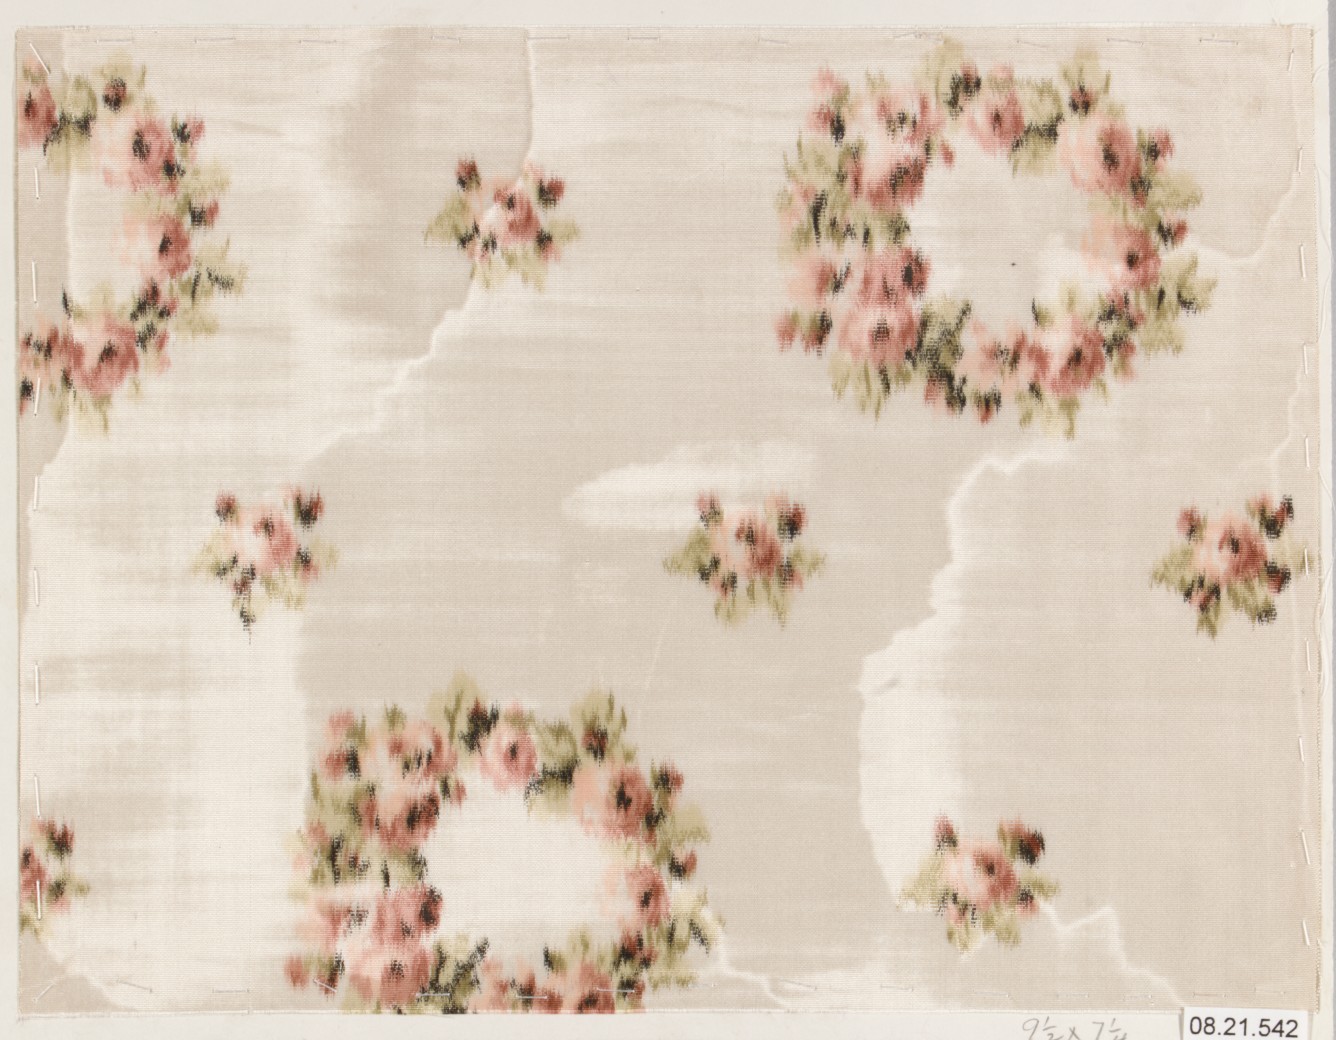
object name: textile sample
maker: Anonymous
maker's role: designer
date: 1900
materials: silk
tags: flowers